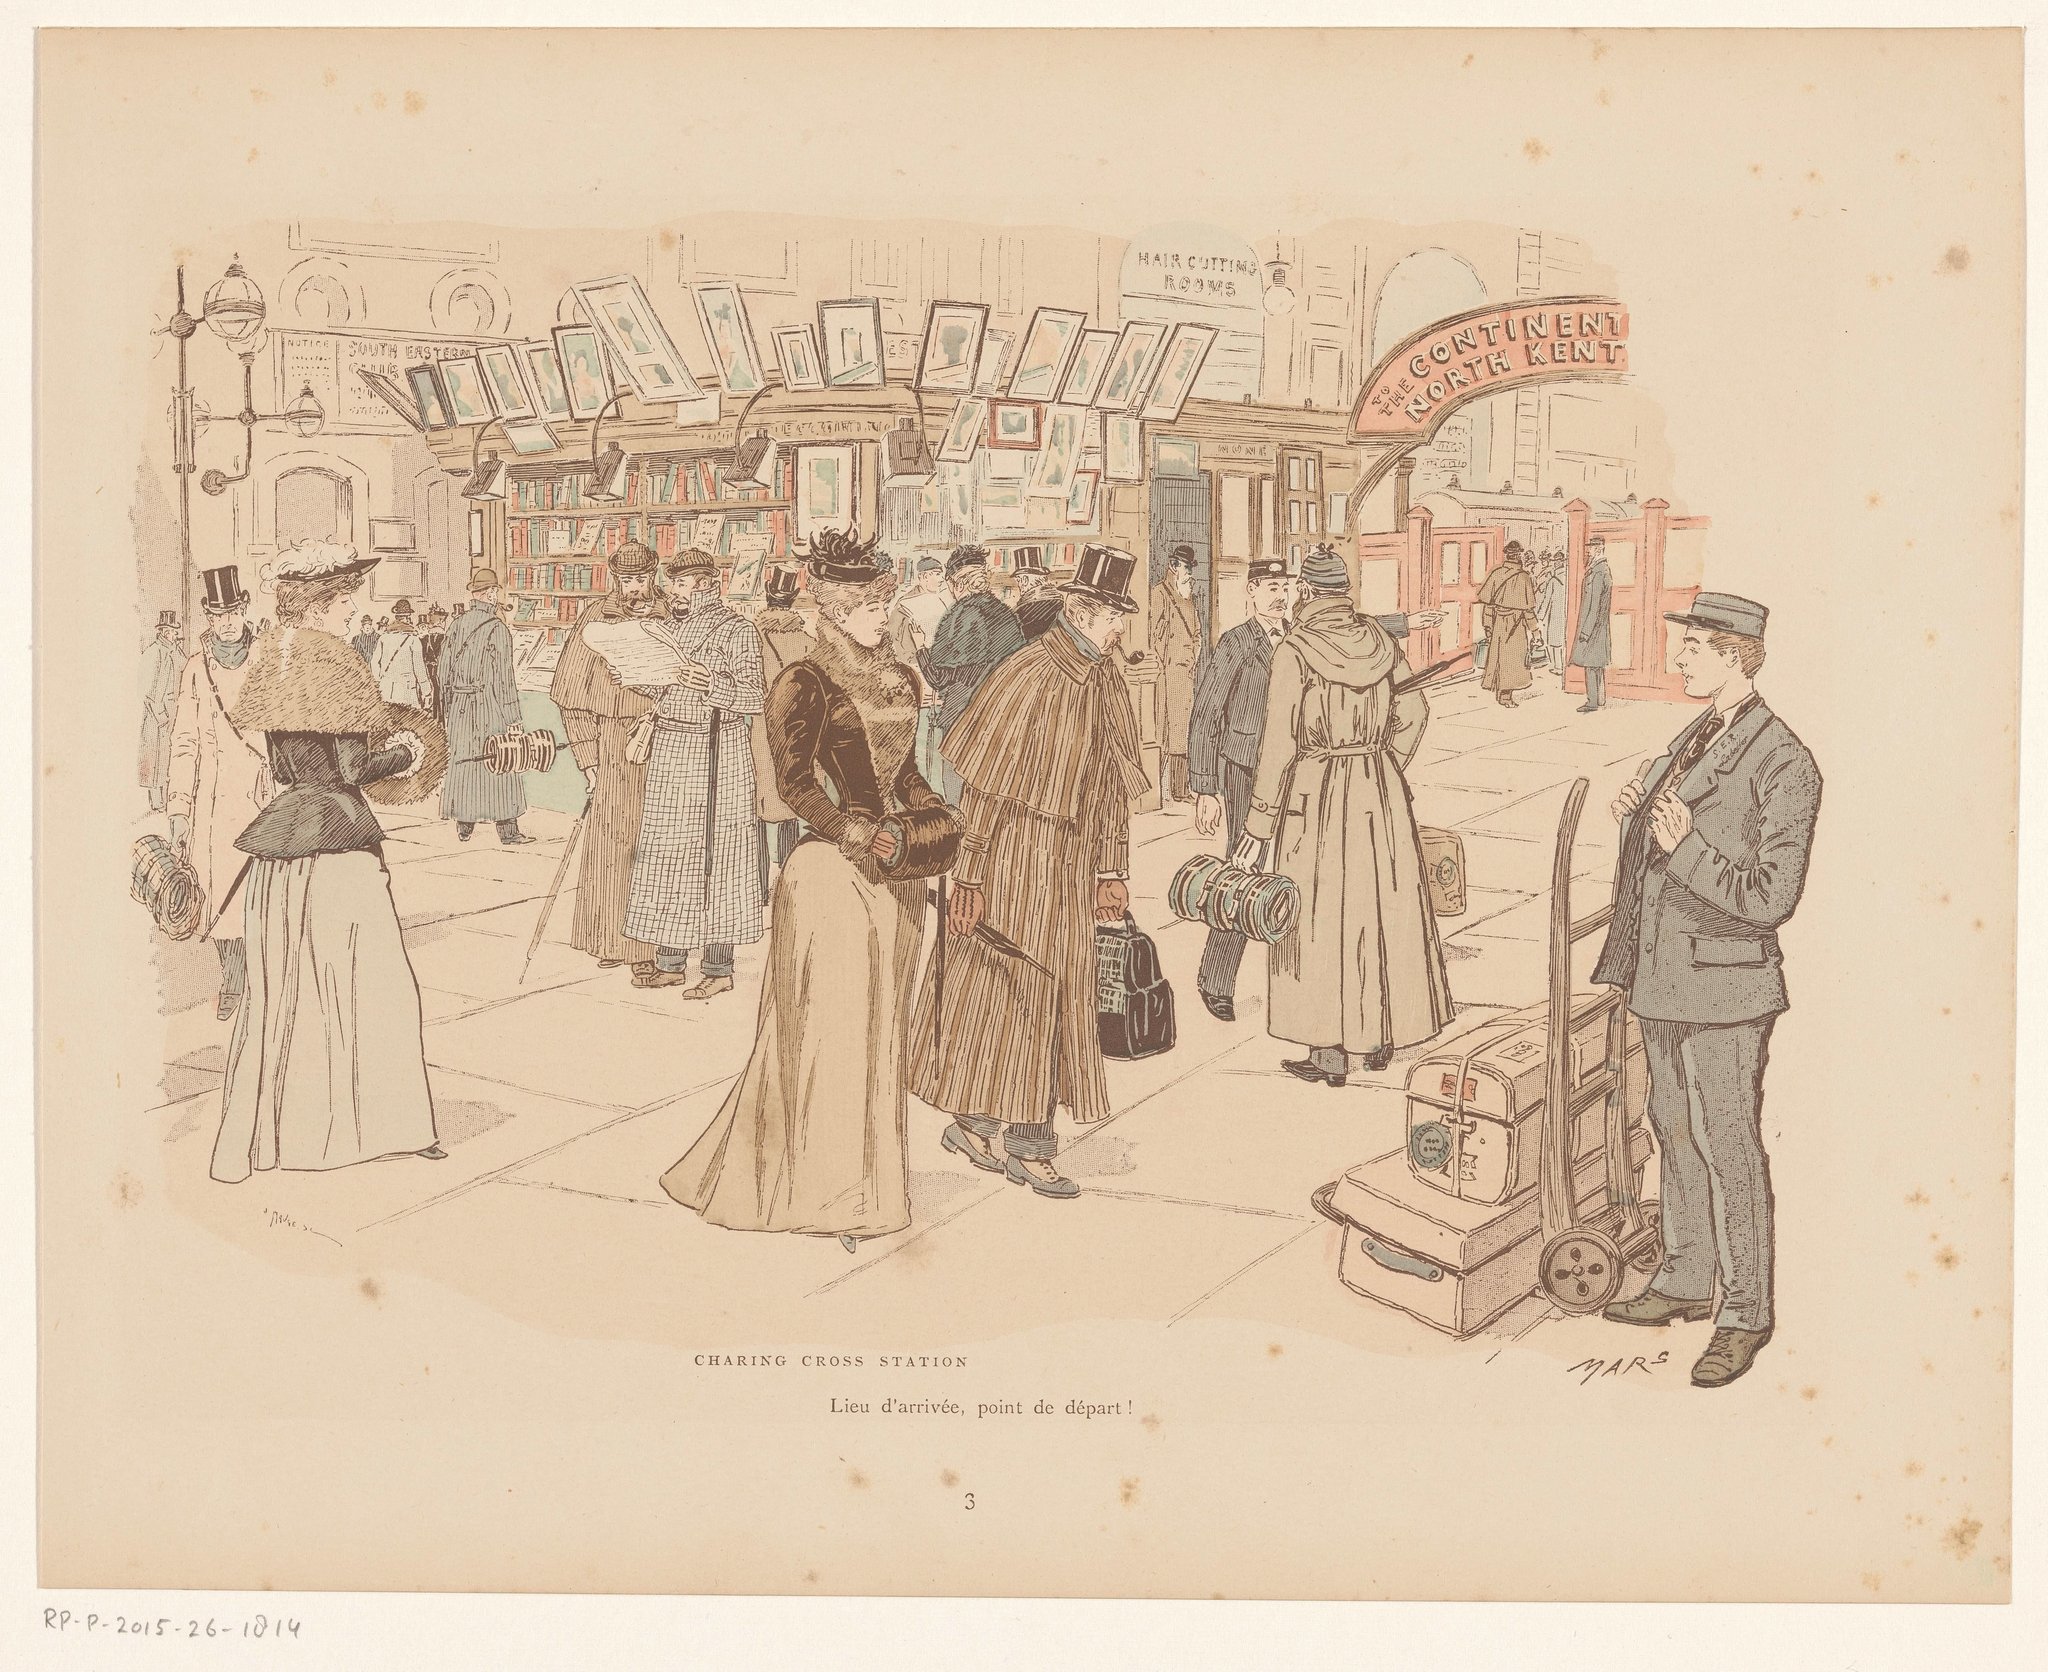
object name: print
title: Charing Cross Station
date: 1864-1912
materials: paper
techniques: hand coloring, lithograph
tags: book-stall, kiosk, station; shelter (railway, tramway)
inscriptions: collector's mark: Lugt 4779, collector's mark: Lugt 4780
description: Reizigers in de hal van Charing Cross Station. Op de voorgrond een kruier met een steekwagen met koffers. In de achtergrond een boekenkraam van W.H. Smith. Midden onder genummerd: 3.